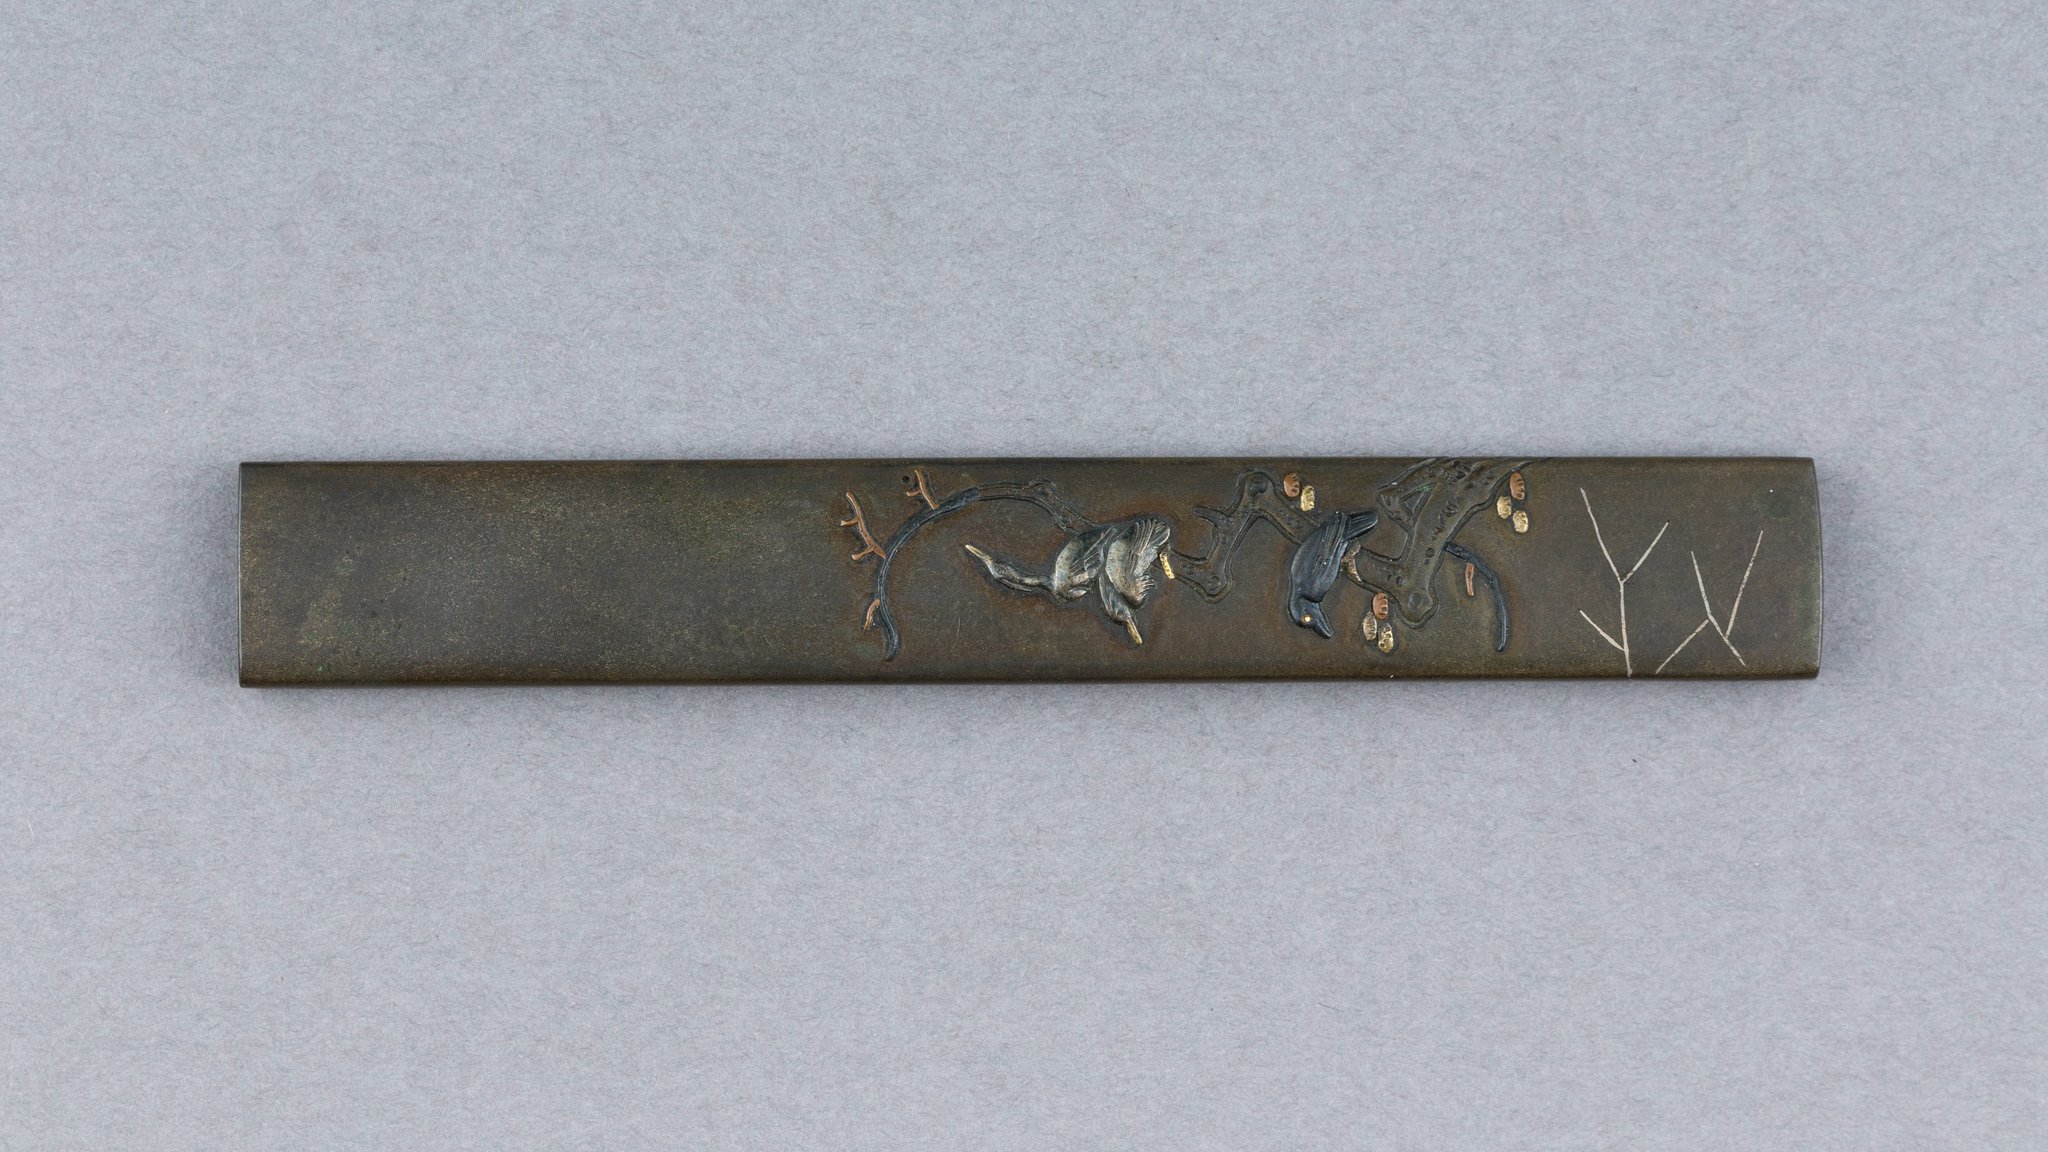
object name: knife handle kozuka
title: Knife Handle (Kozuka)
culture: japanese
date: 1615-1868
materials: copper, gold alloy, silver alloy, gold, silver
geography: japan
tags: birds